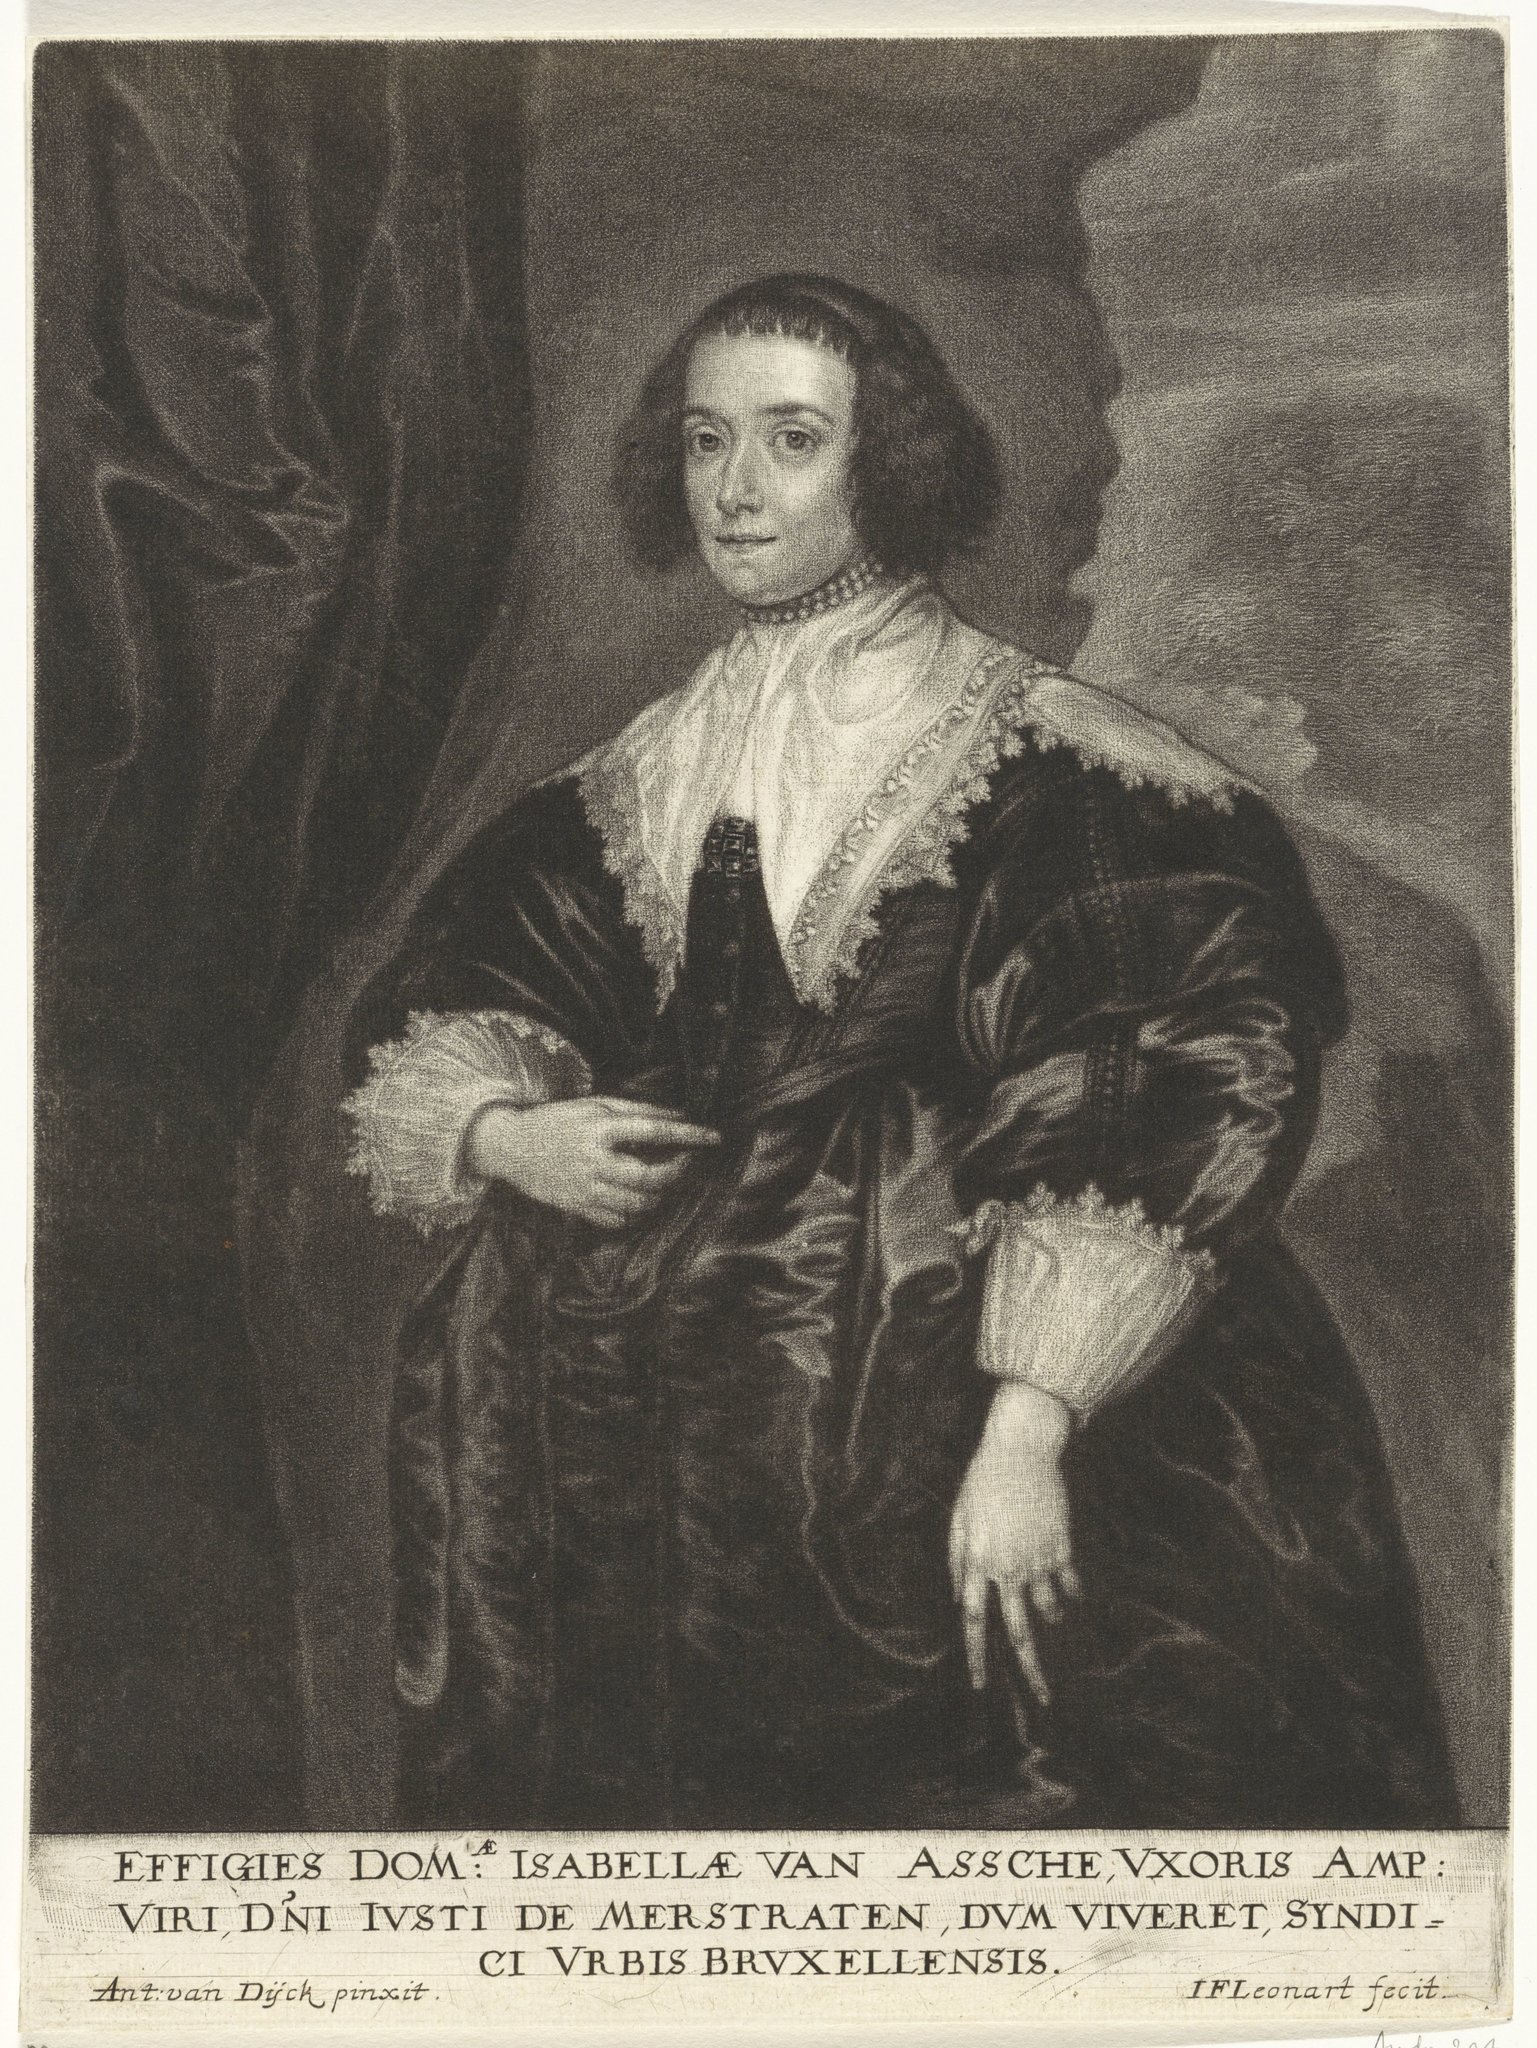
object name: print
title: Portret van Isabella van Asche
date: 1643-1680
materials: paper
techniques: engraving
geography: brussels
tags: isabella van asche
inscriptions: collector's mark: Lugt 240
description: Pendant van 'Portret van Justus van Meerstraten', door dezelfde prentmaker.